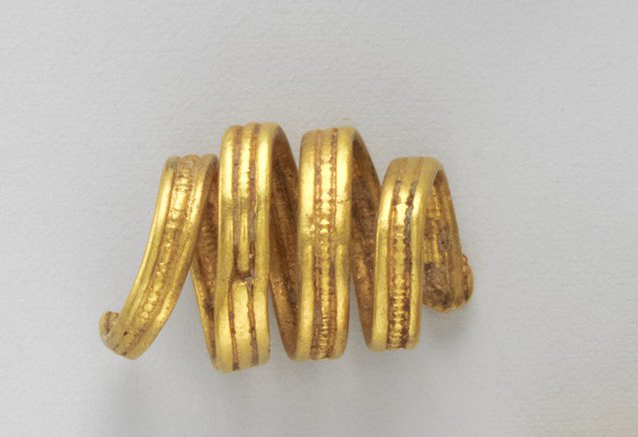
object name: spiral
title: Gold spiral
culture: etruscan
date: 700-501 BCE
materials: gold